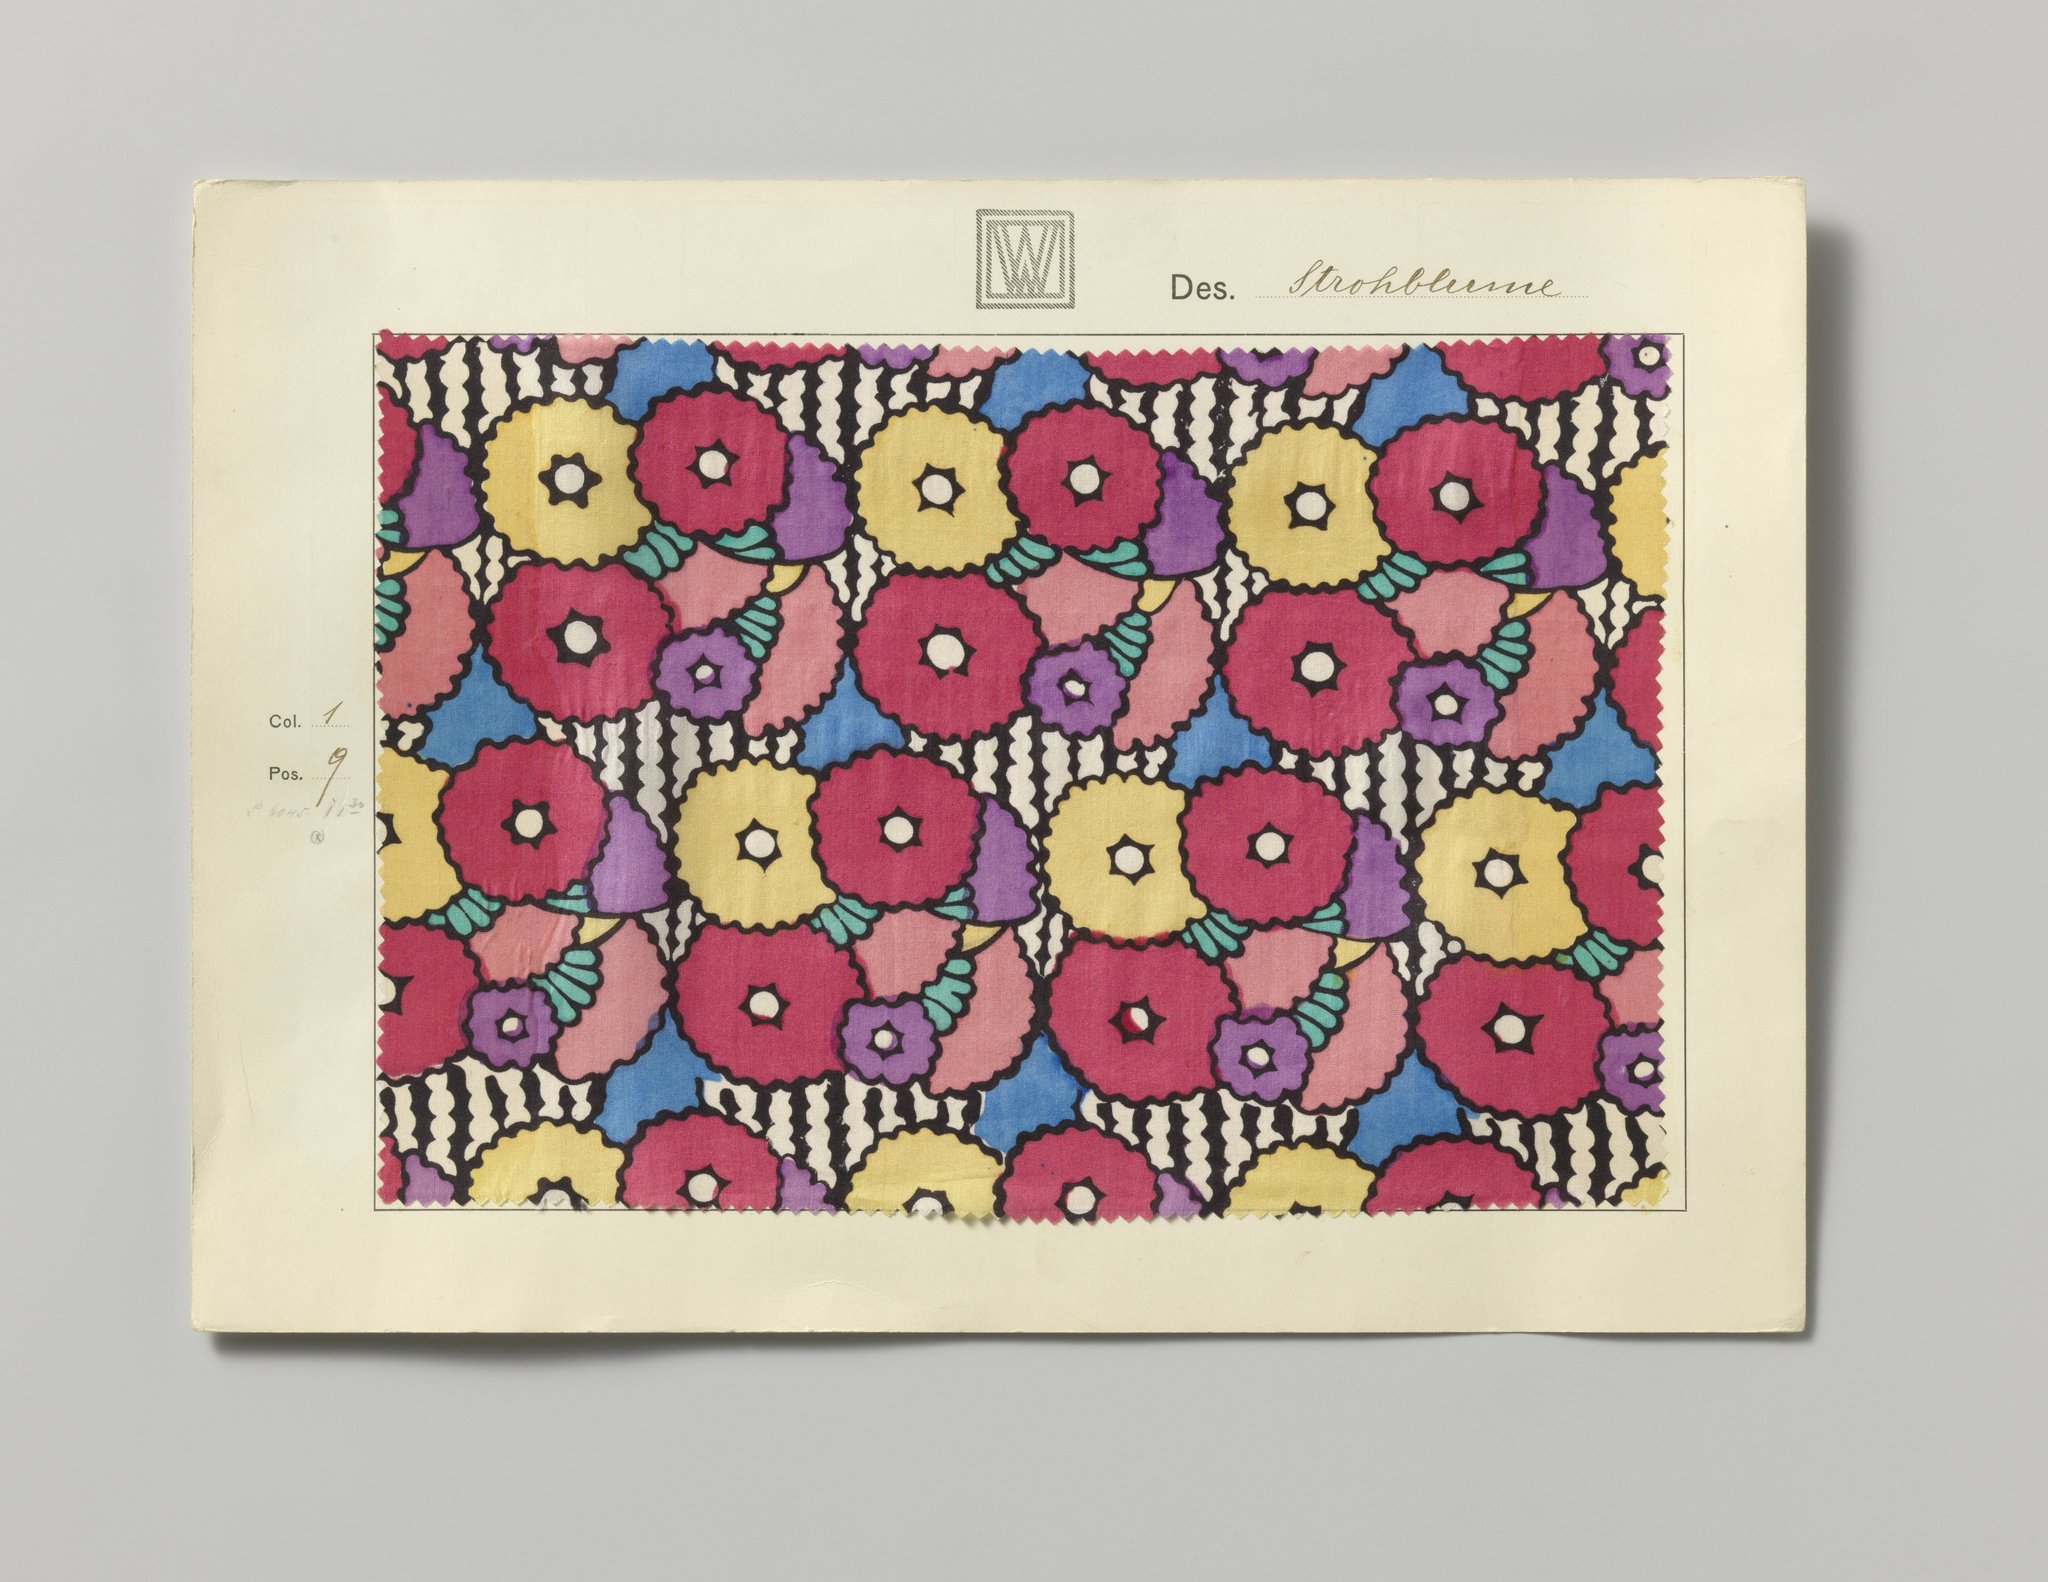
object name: sample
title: Staal met bedrukte zijde, dessin Strohblume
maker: marie rosalie friedman-otten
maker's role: designer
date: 1910-1914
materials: cardboard, silk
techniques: printing block, weave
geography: vienna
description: Staal met bedrukte zijde. Dessin Strohblume, WW nr. 00498. Op naturel fond bloemendessin in geel, twee tinten roze, paars, blauw, groen en zwart, met contouren in zwart. De staal is gelijmd op karton waarop het vignet van de Wiener Werkstätte